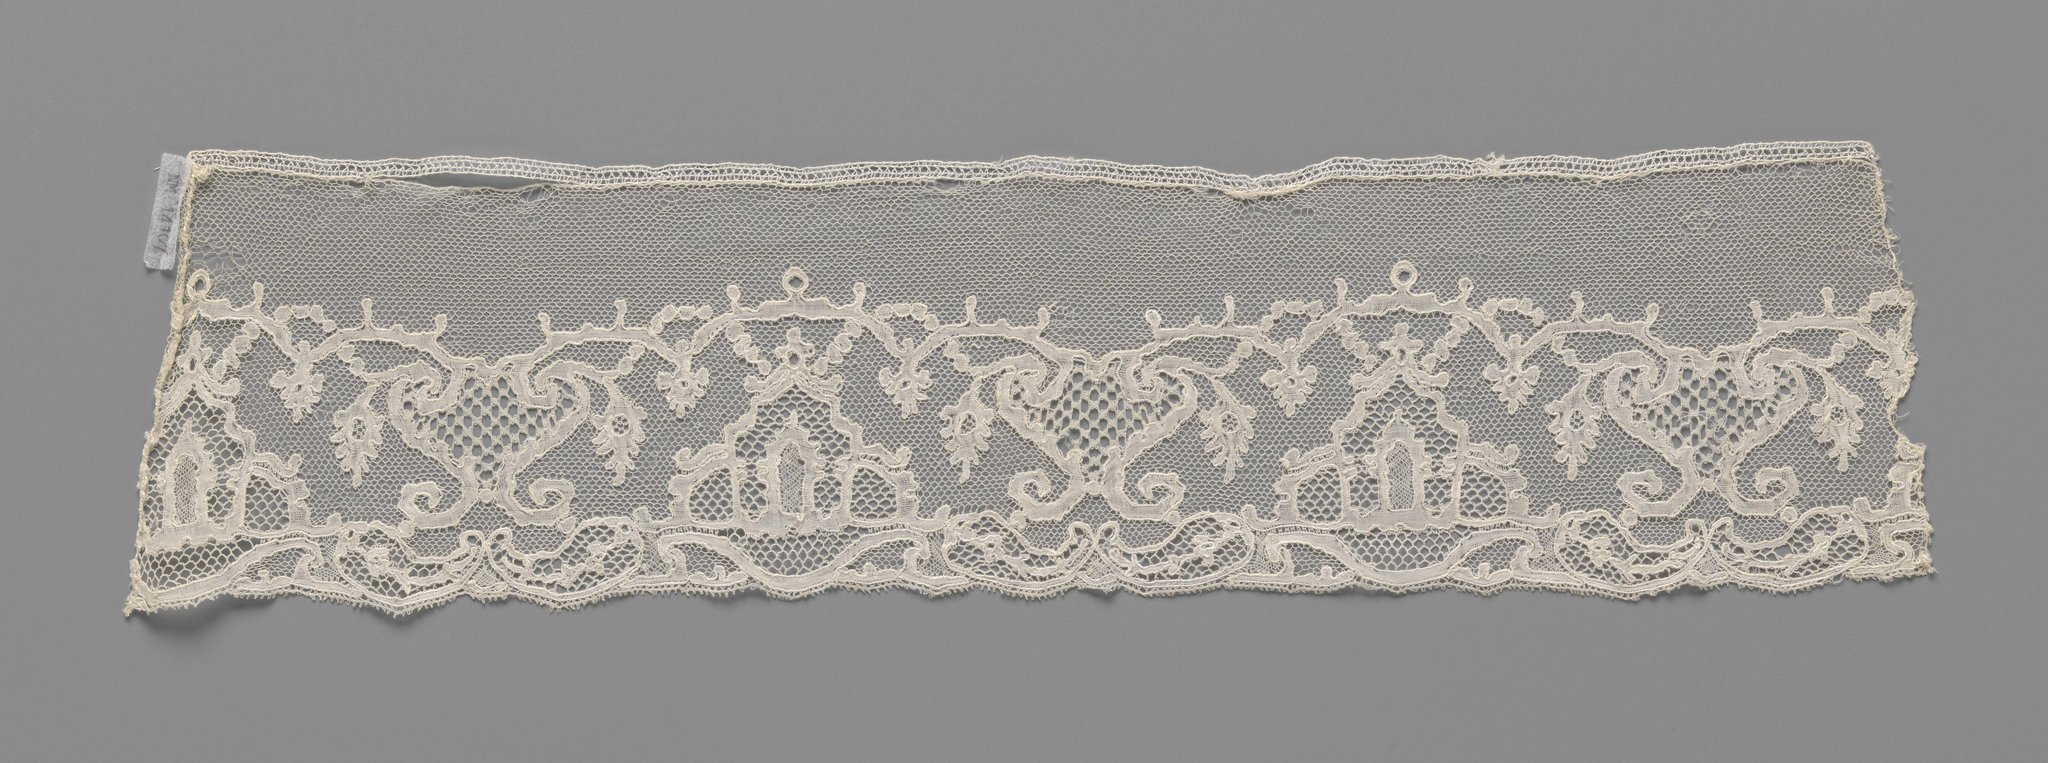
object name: strip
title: Strook kloskant met symmetrische composities met hartvormige vaas en driehoekig architectonisch motief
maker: Anonymous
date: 1840-1849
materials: linen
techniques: lace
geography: belgium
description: Strook naturelkleurige kloskant: Rijselse kant. Het zich herhalende patroon bestaat uit twee in elkaar overlopende symmetrische composities. In het centrum van de ene compositie staat een door s-voluten gevormde hartvormige vaas. In het centrum van de andere compositie staat een driehoekig architectonisch motief. Langs de onderrand vormen verschillende voluten een vlakke schulpenrand. De motieven zijn grotendeels gemaakt in linnenslag en voorzien van dikkere en glimmende contourdraden. Enkele motieven of vullingen zijn gemaakt in netslag. De motieven zijn met elkaar verbonden door een fijne traliegrond, een tulegrond. In de motieven zijn grovere siergronden toegepast. De bovenzijde is recht afgewerkt met een apart geklost bandje. De vlakke schulpenrand is afgewerkt met picots.